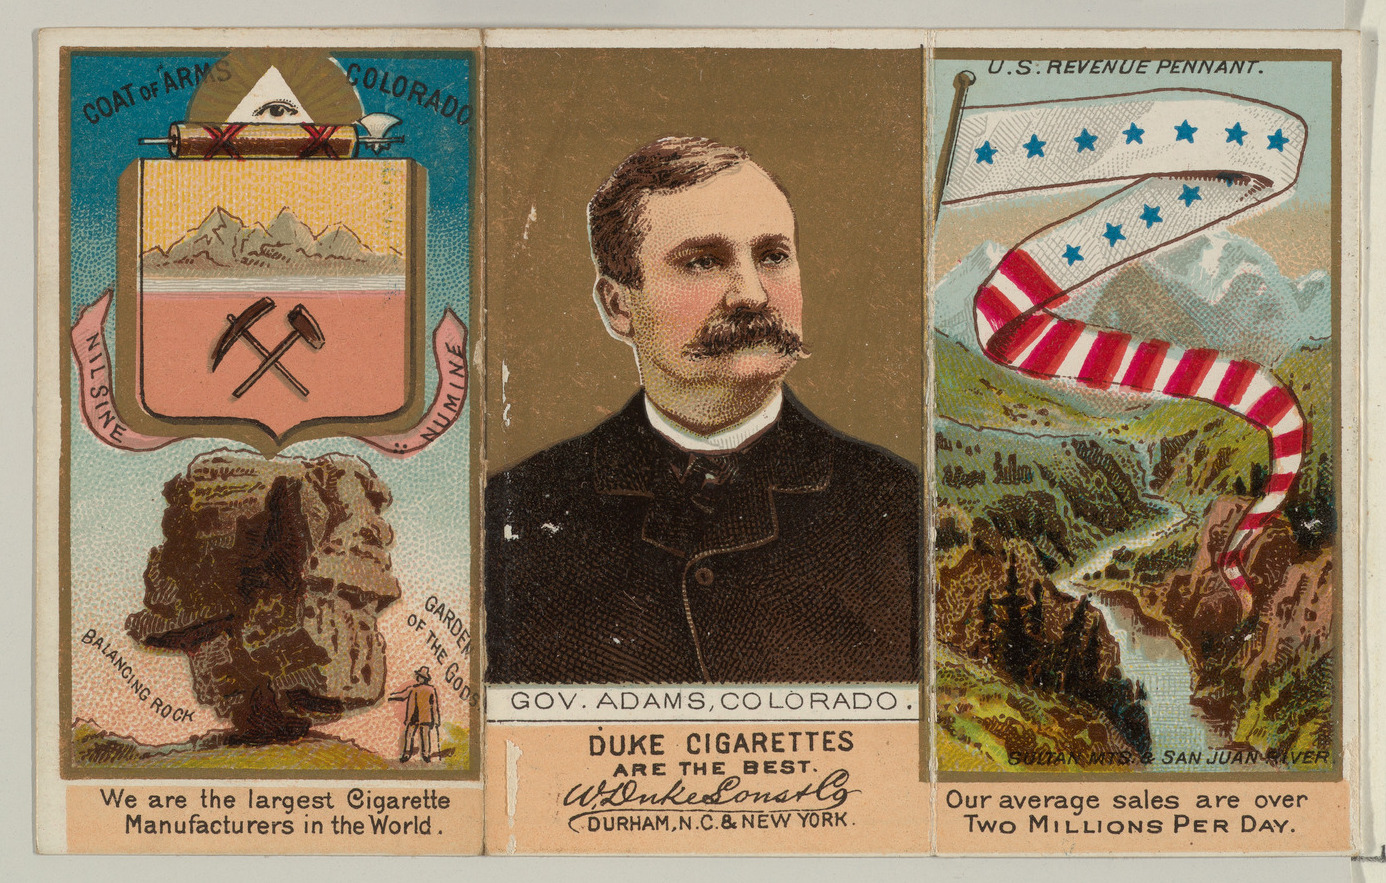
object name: print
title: Governor Adams, Colorado, from "Governors, Arms, Etc." series (N133-2), issued by Duke Sons & Co.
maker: w. duke, sons & co.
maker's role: publisher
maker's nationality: american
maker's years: 1870-1920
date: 1888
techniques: color lithograph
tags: men,portraits,rivers,coat of arms,flags